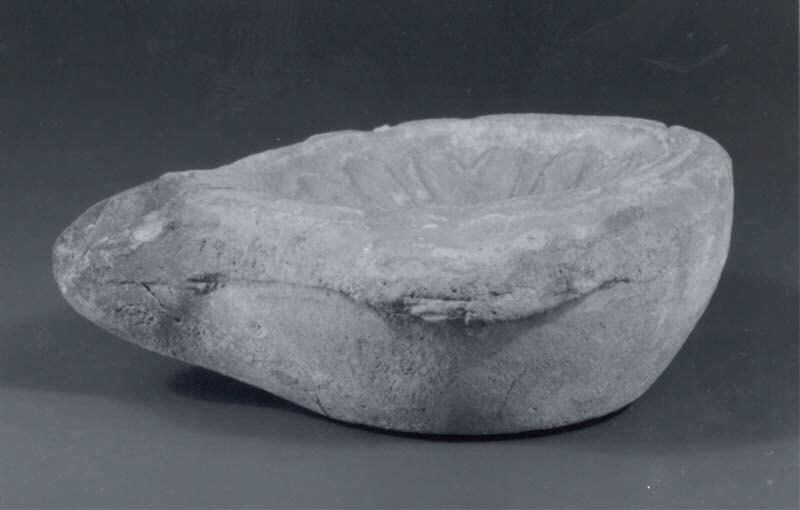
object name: lamp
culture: nabataean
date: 1-100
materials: ceramic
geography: levant